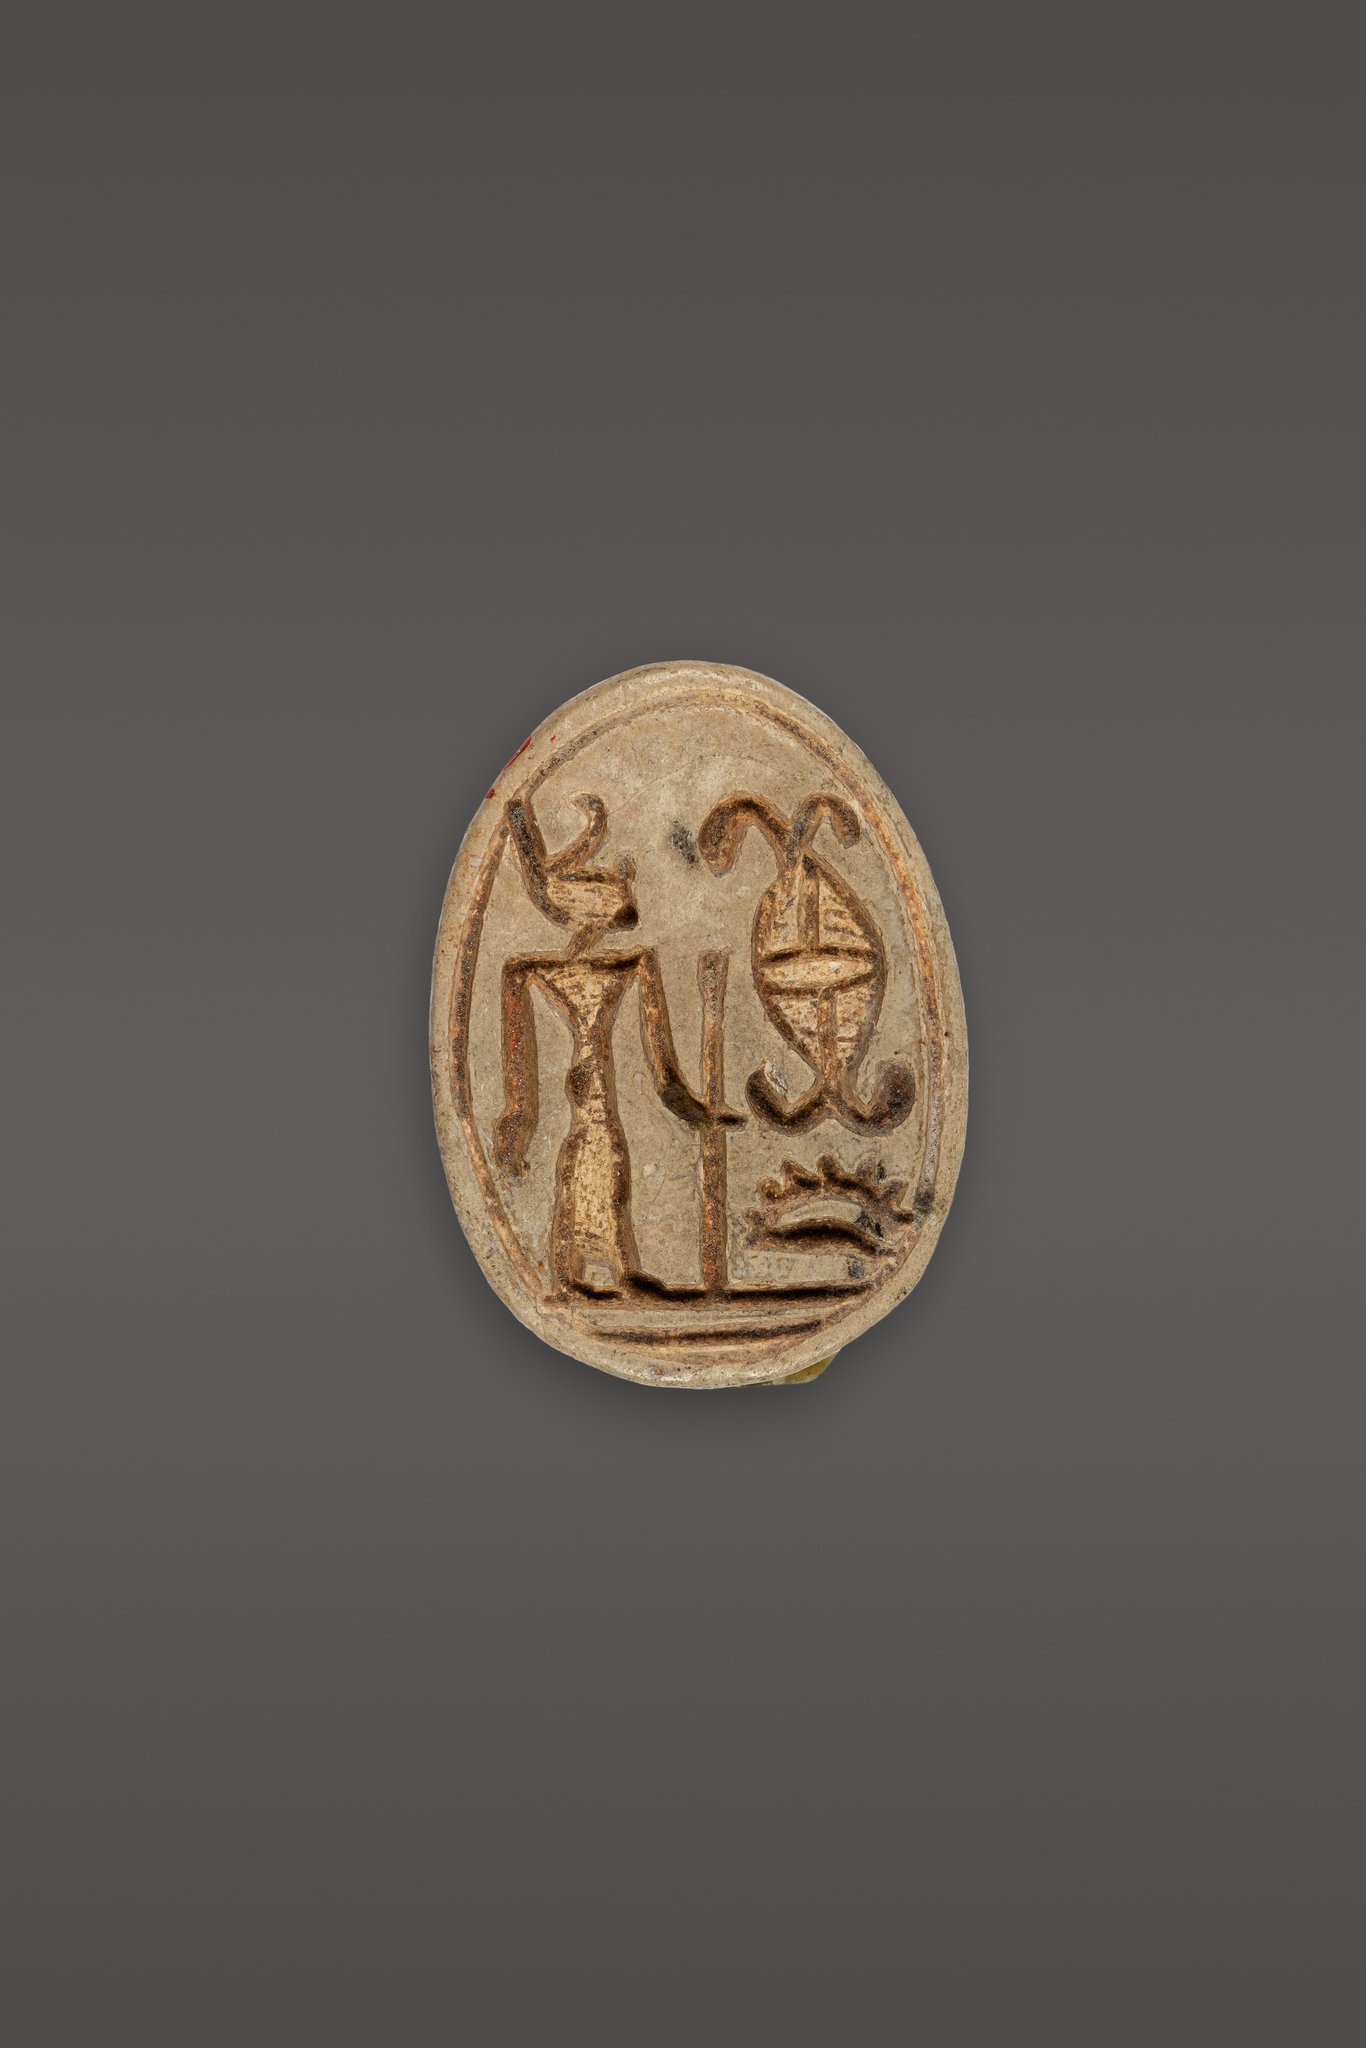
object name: scarab, neit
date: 1640-1550 BCE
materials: stone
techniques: glazing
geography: egypt